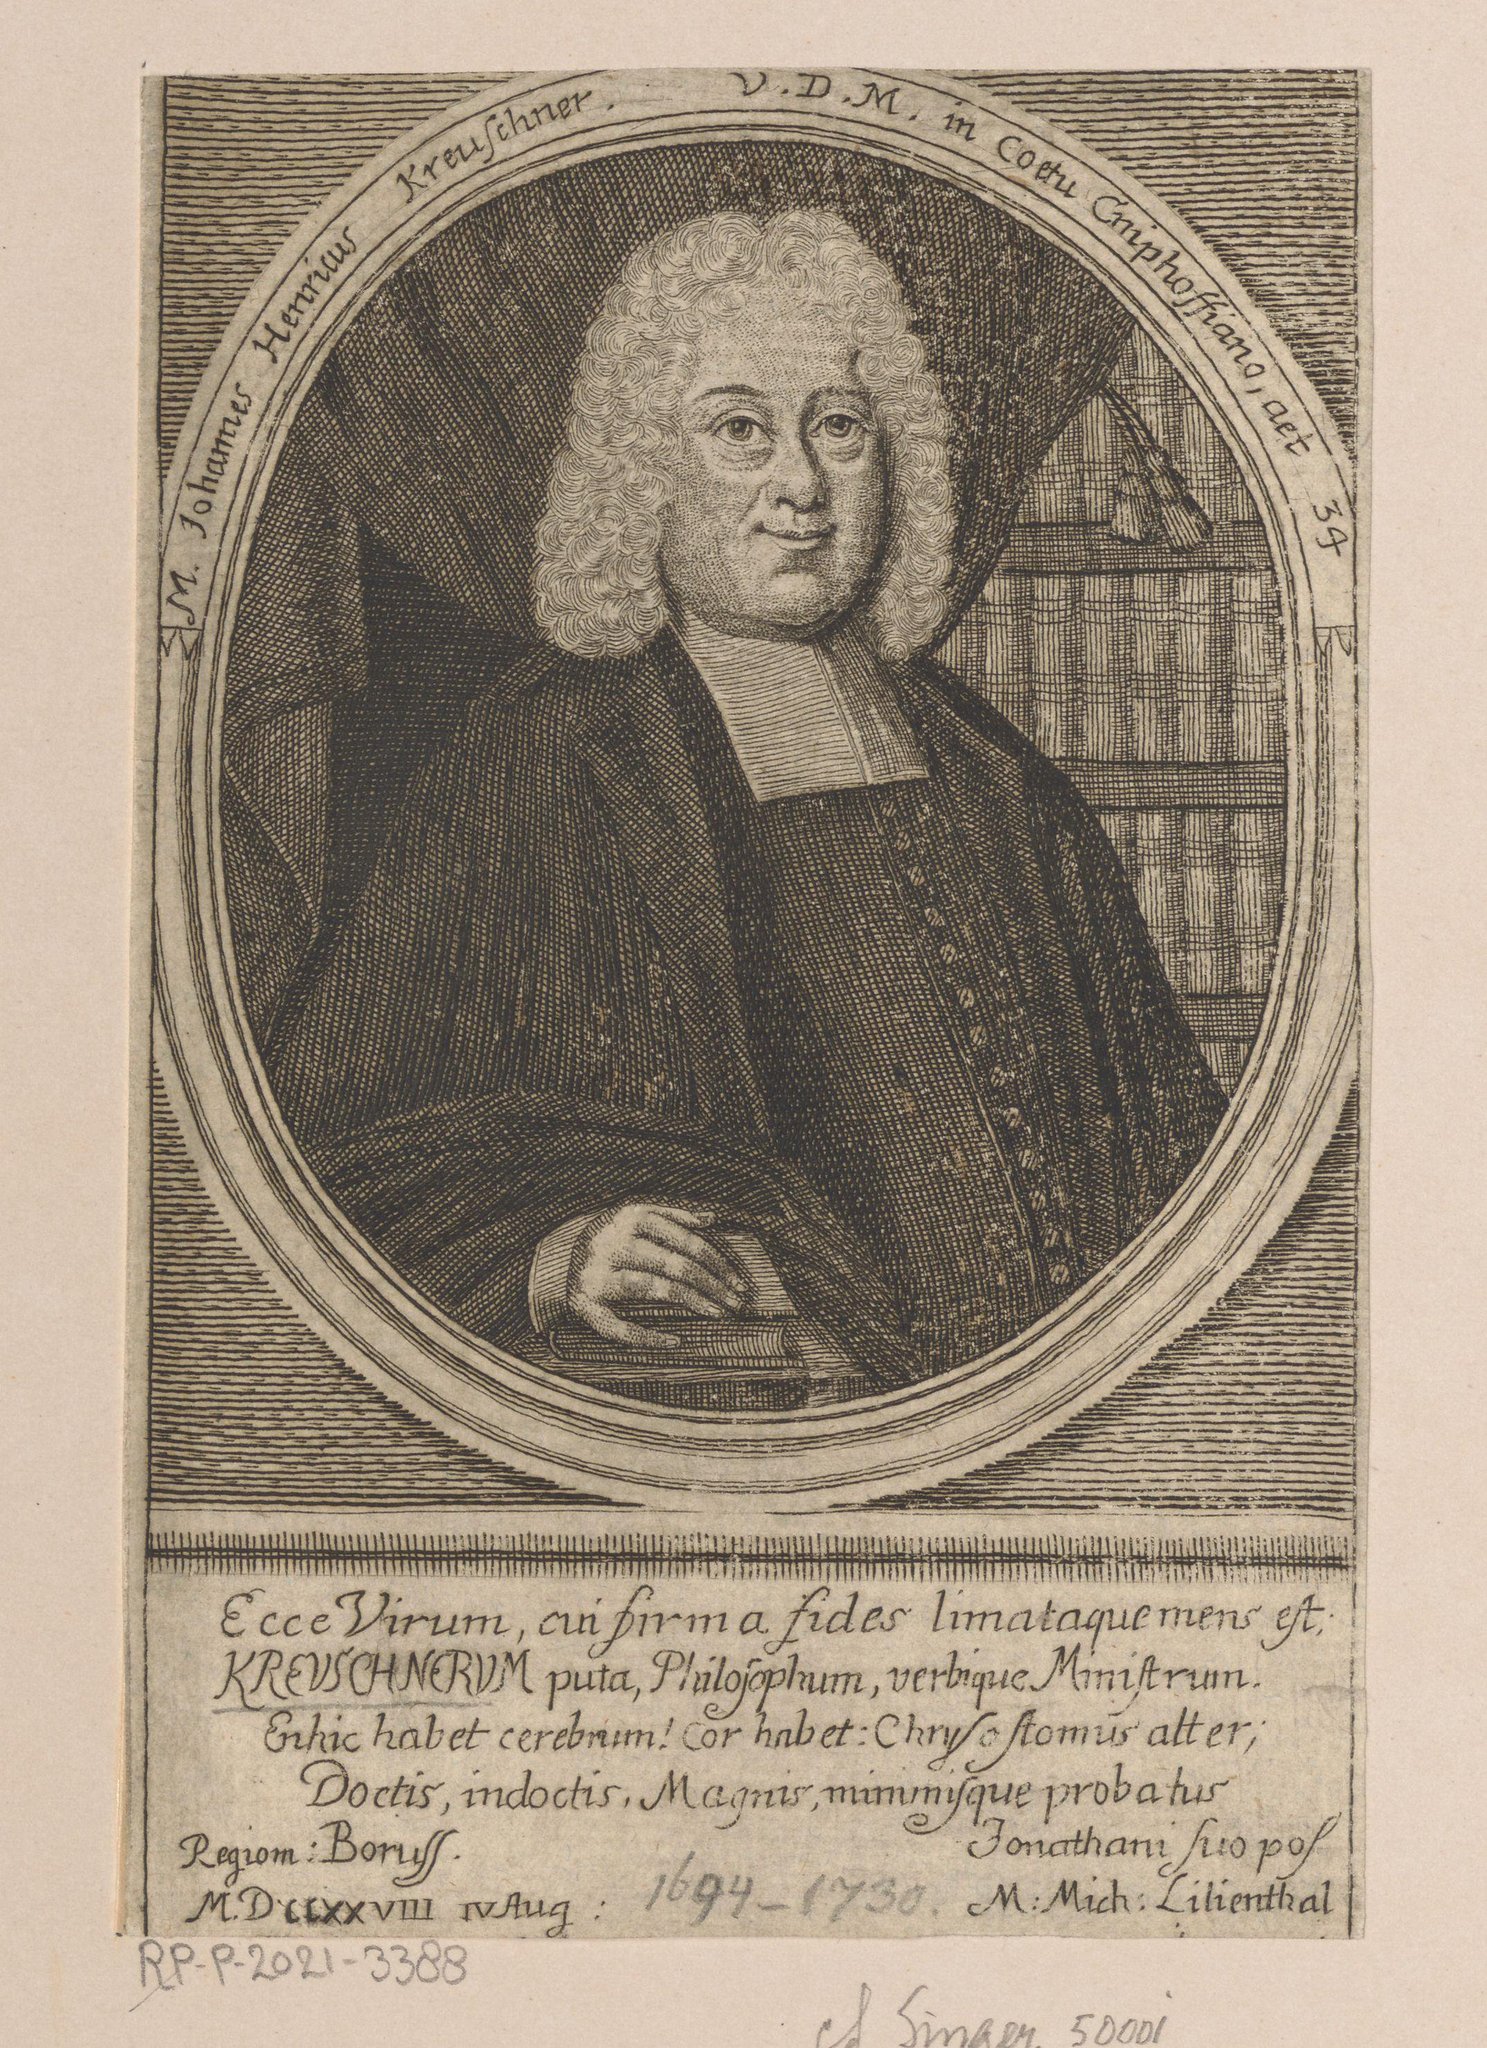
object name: print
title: Portret van Johann Heinrich Kreuschner op 34-jarige leeftijd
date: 1728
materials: paper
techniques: engraving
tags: historical persons, book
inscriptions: date